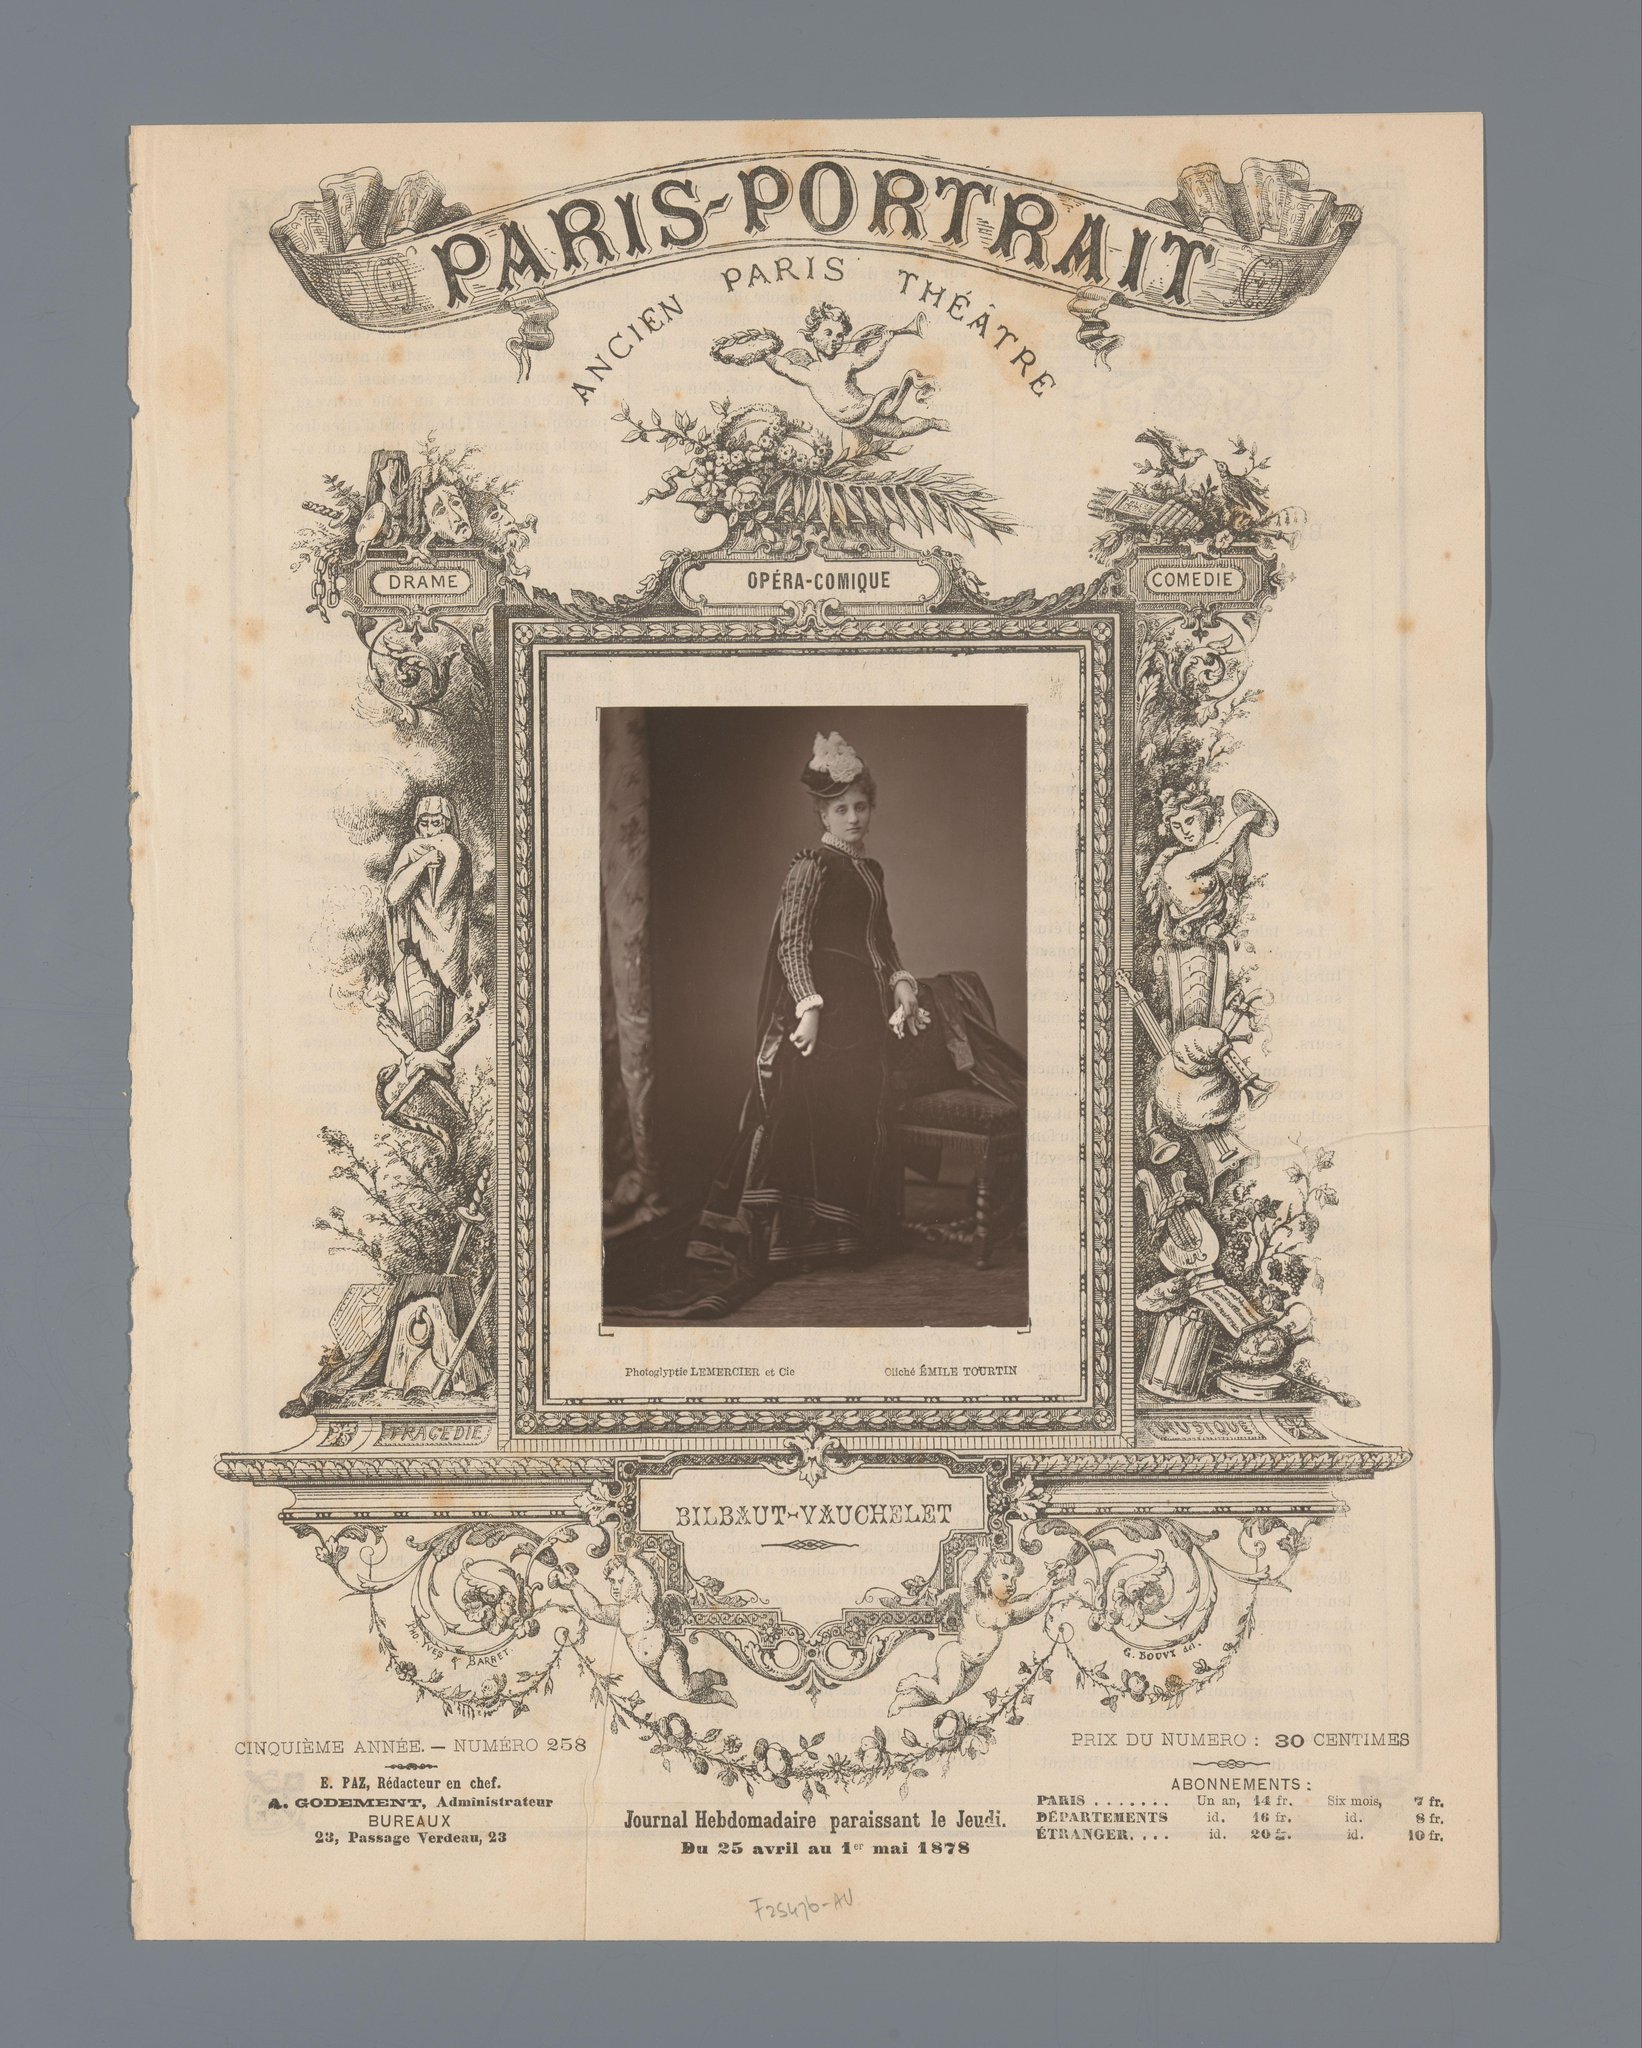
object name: photomechanical print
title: Portret van Juliette Bilbaut-Vauchelet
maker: emile tourtin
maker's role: fotograaf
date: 1872-1879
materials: paper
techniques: woodburytype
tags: historical persons - bb - woman